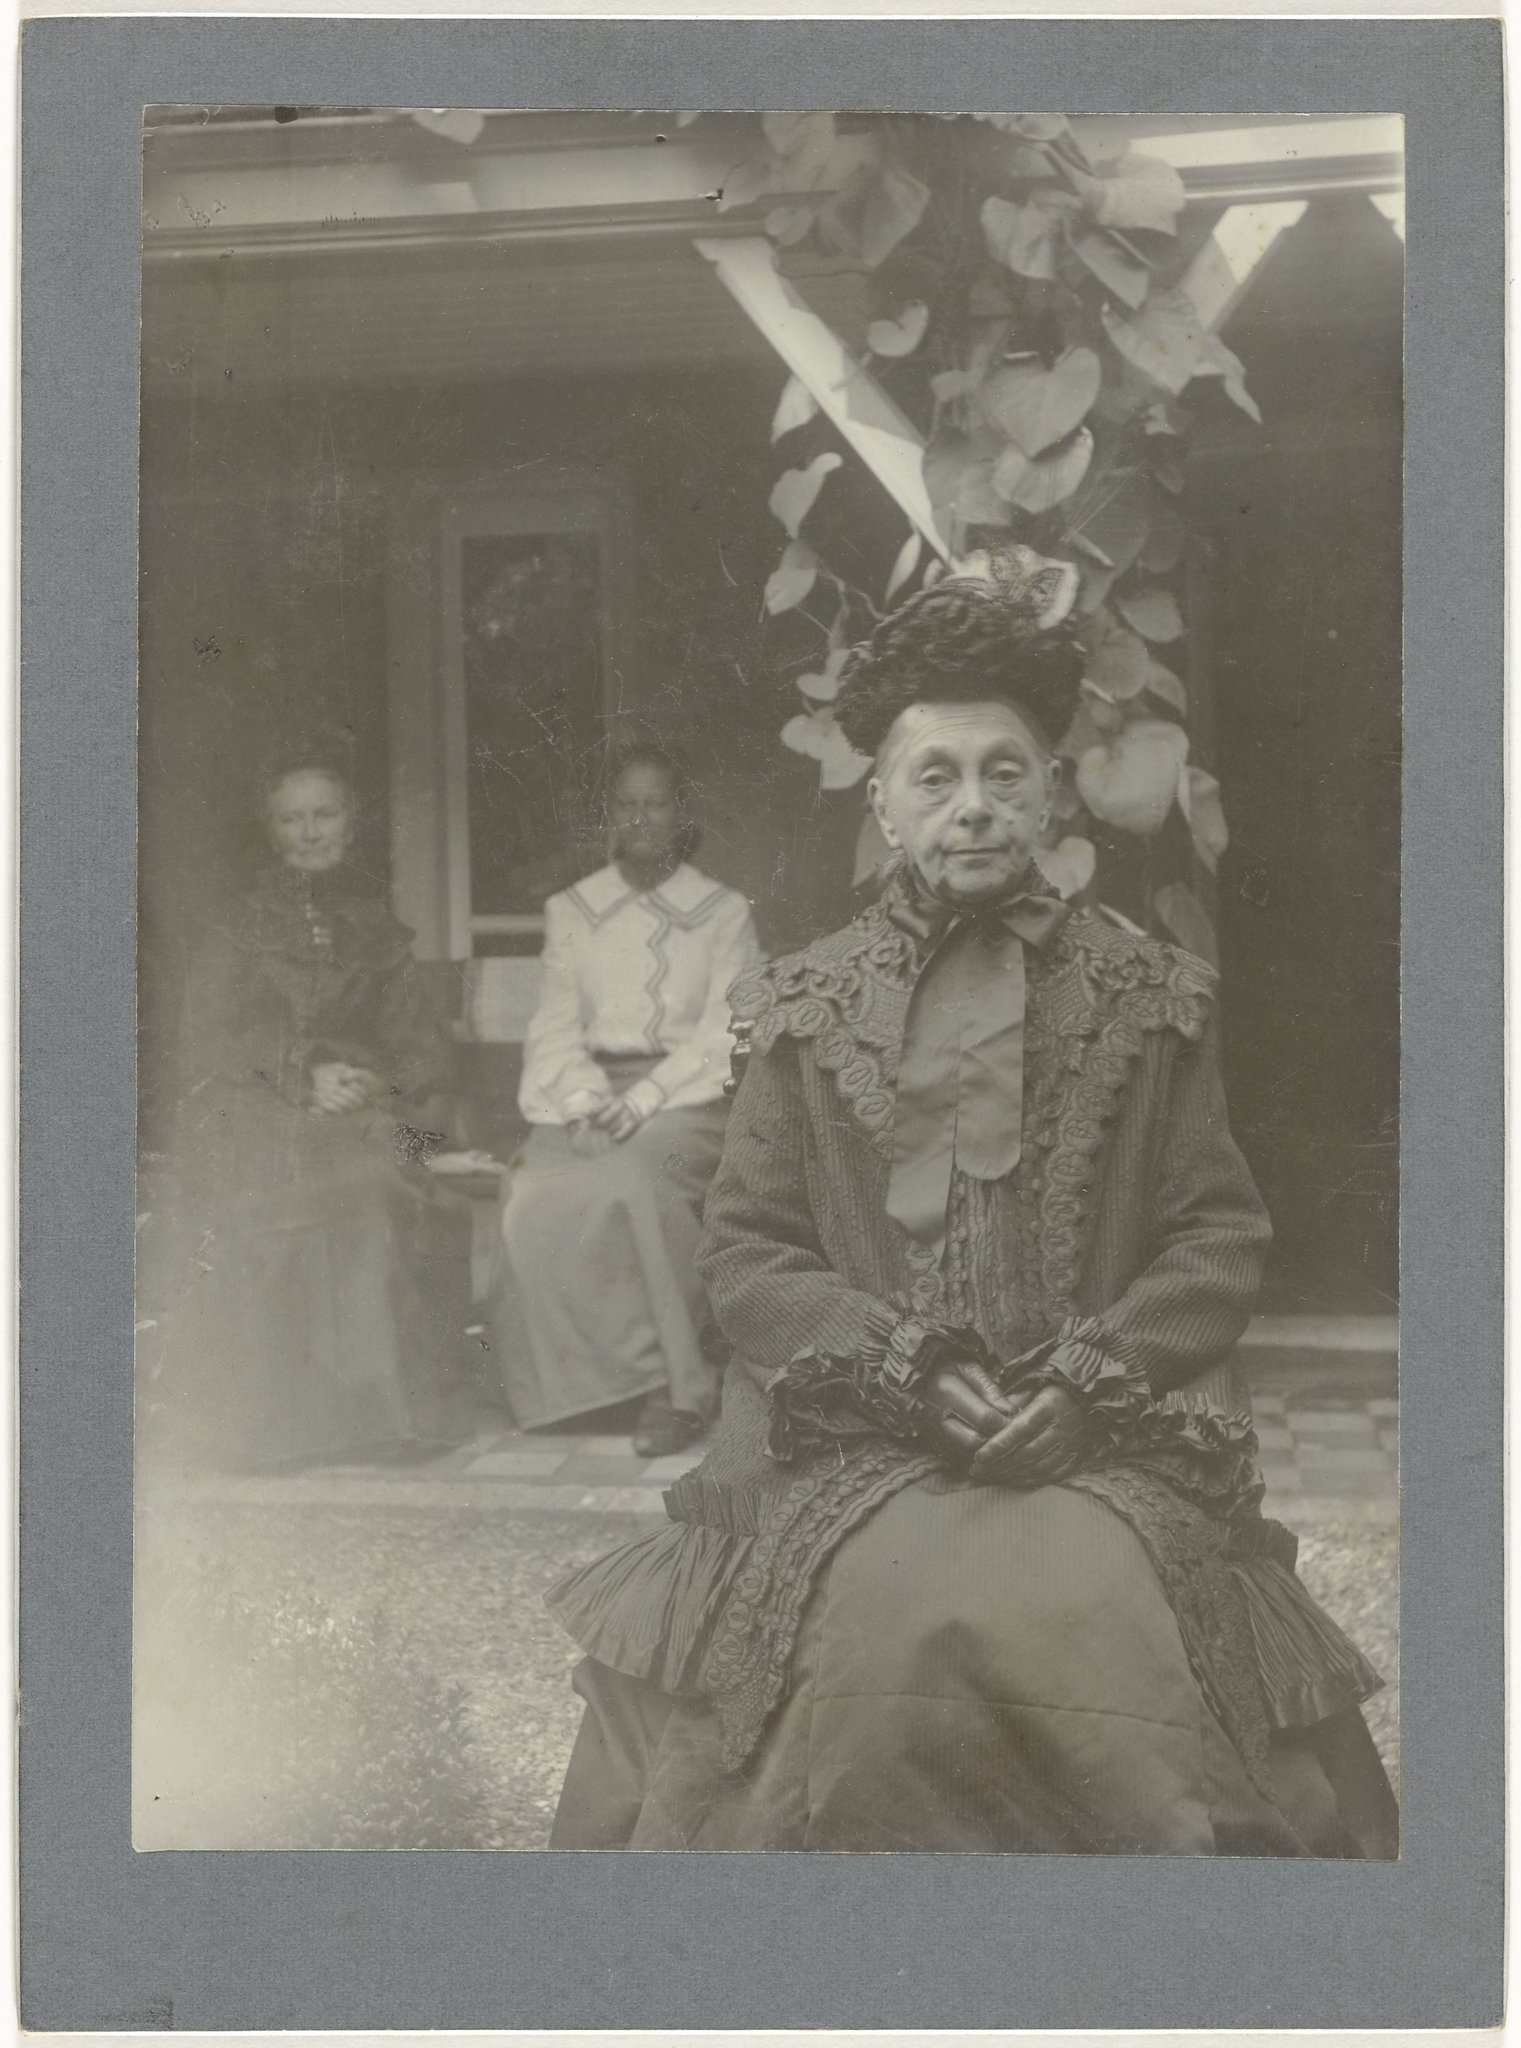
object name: photograph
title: Portret van een oude vrouw in rouwkleding, met twee andere vrouwen op de achtergrond, Den Haag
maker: Anonymous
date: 1904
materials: cardboard, paper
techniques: gelatin silver print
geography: netherlands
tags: historical persons not known by name - bb - woman, mourning dress, the hague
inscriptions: inscription: ‘Den Haag 11 Sept ’04’